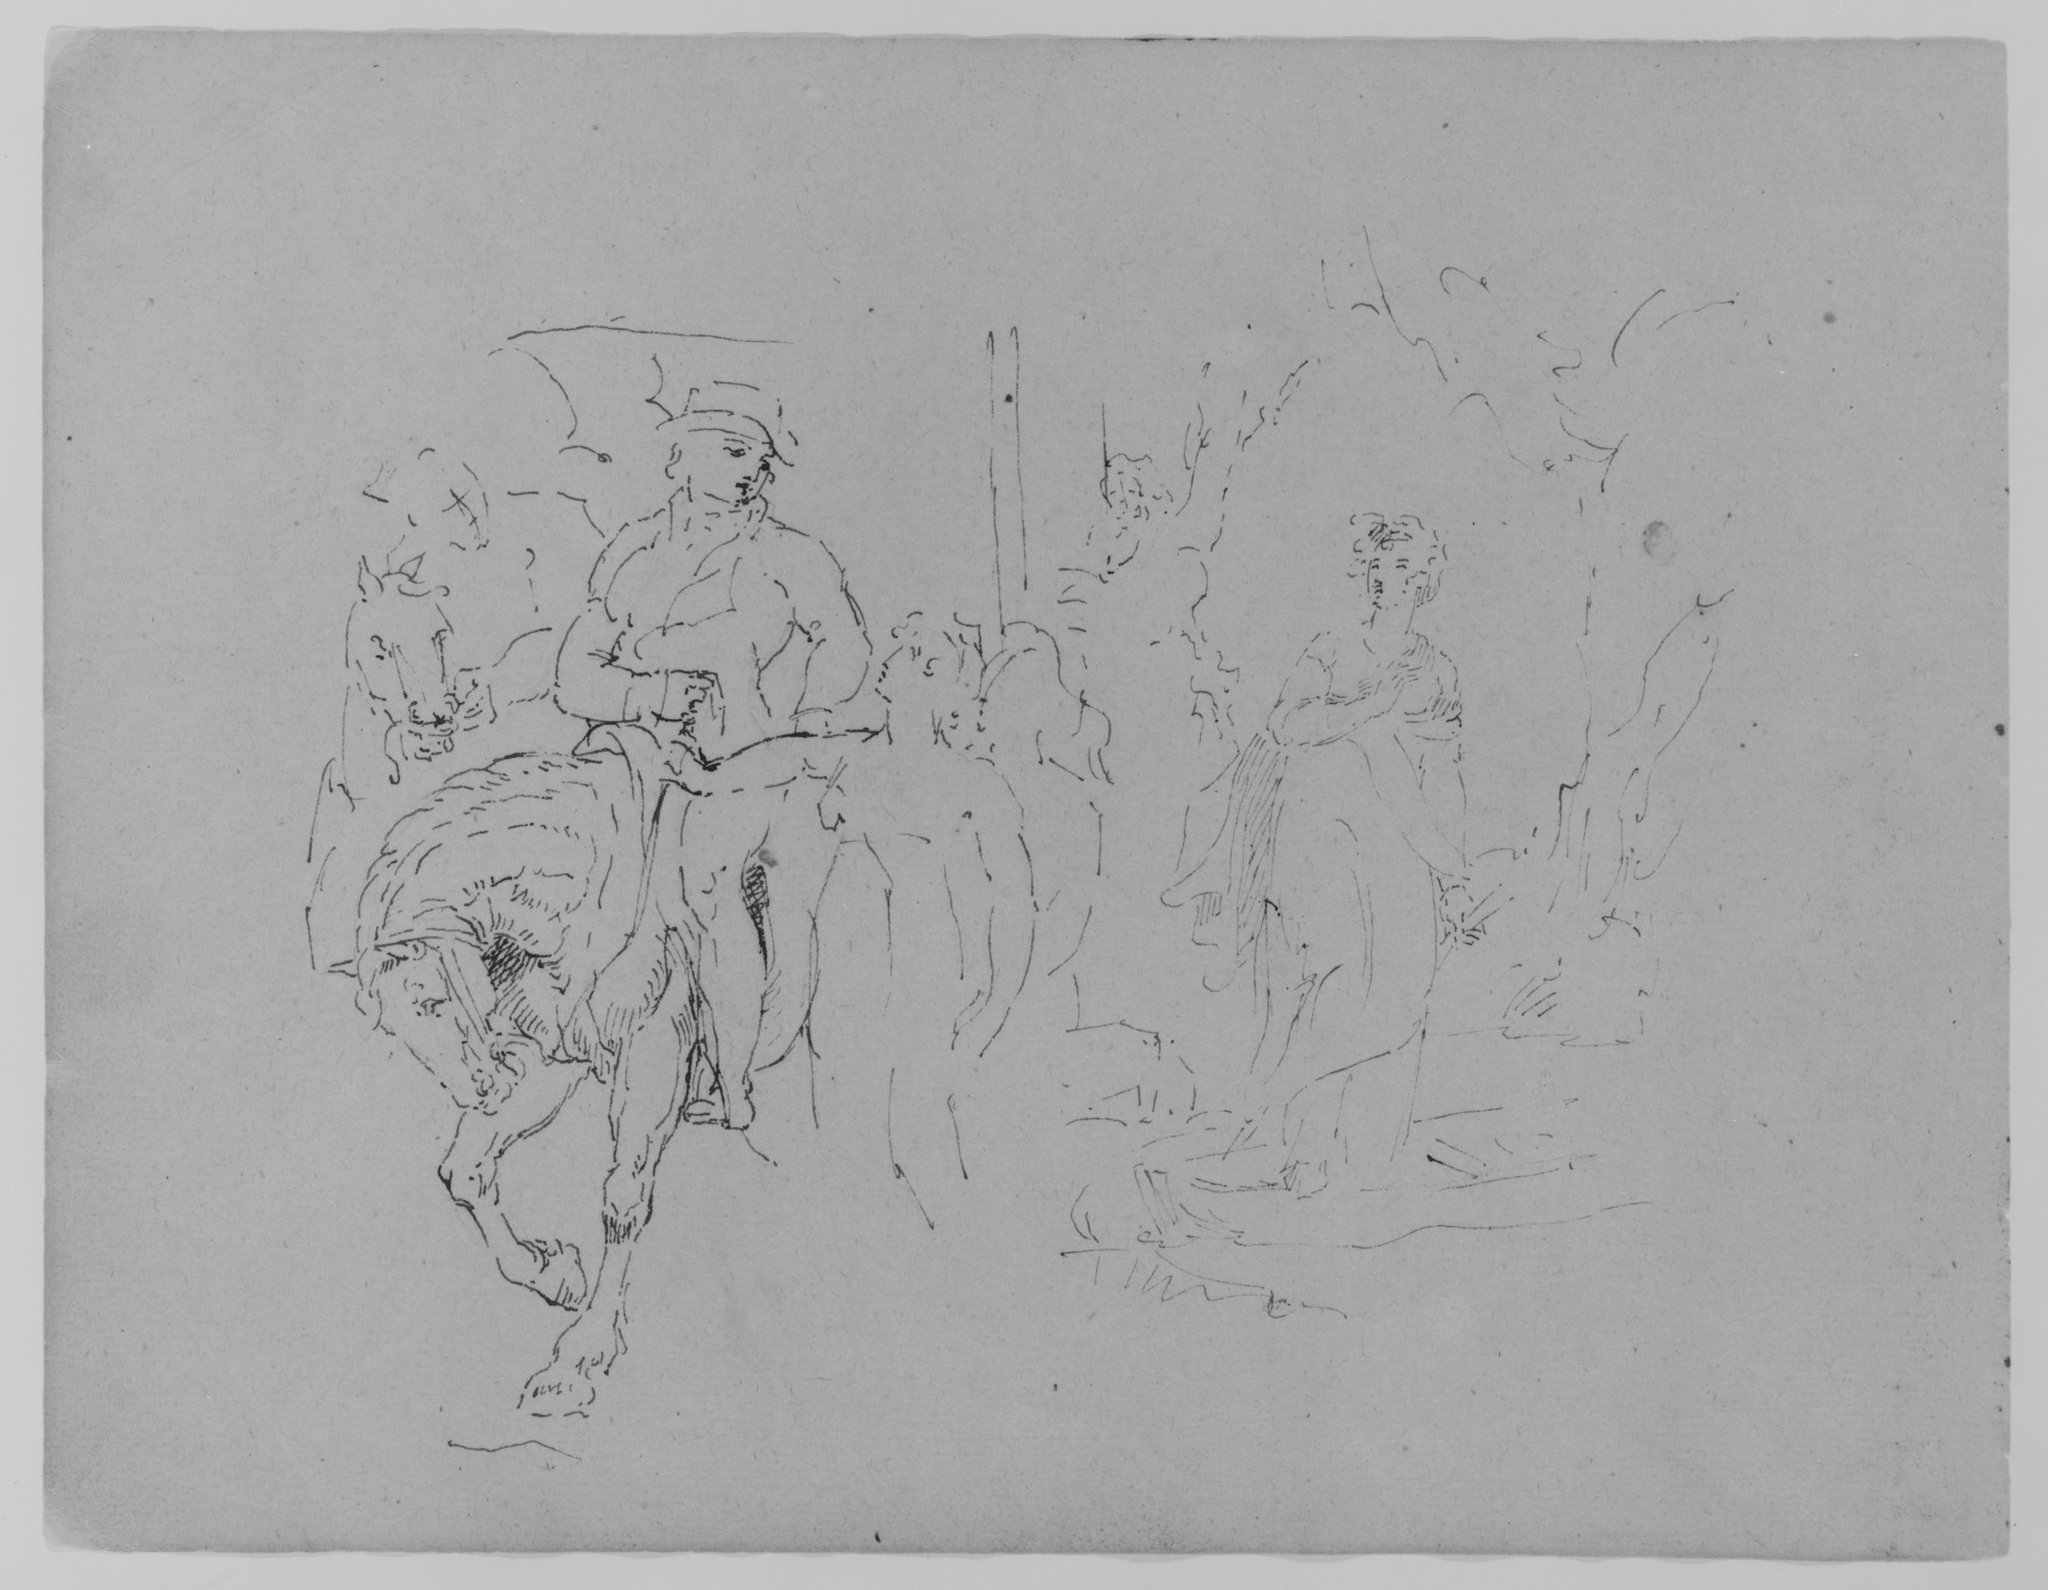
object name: drawing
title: Man on Horseback with Standing Figure; Female in a Landscape (from Sketchbook)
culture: american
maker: thomas sully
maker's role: artist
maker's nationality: american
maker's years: 1783-1872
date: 1810-1820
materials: ink, paper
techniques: wash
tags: men,women,horses